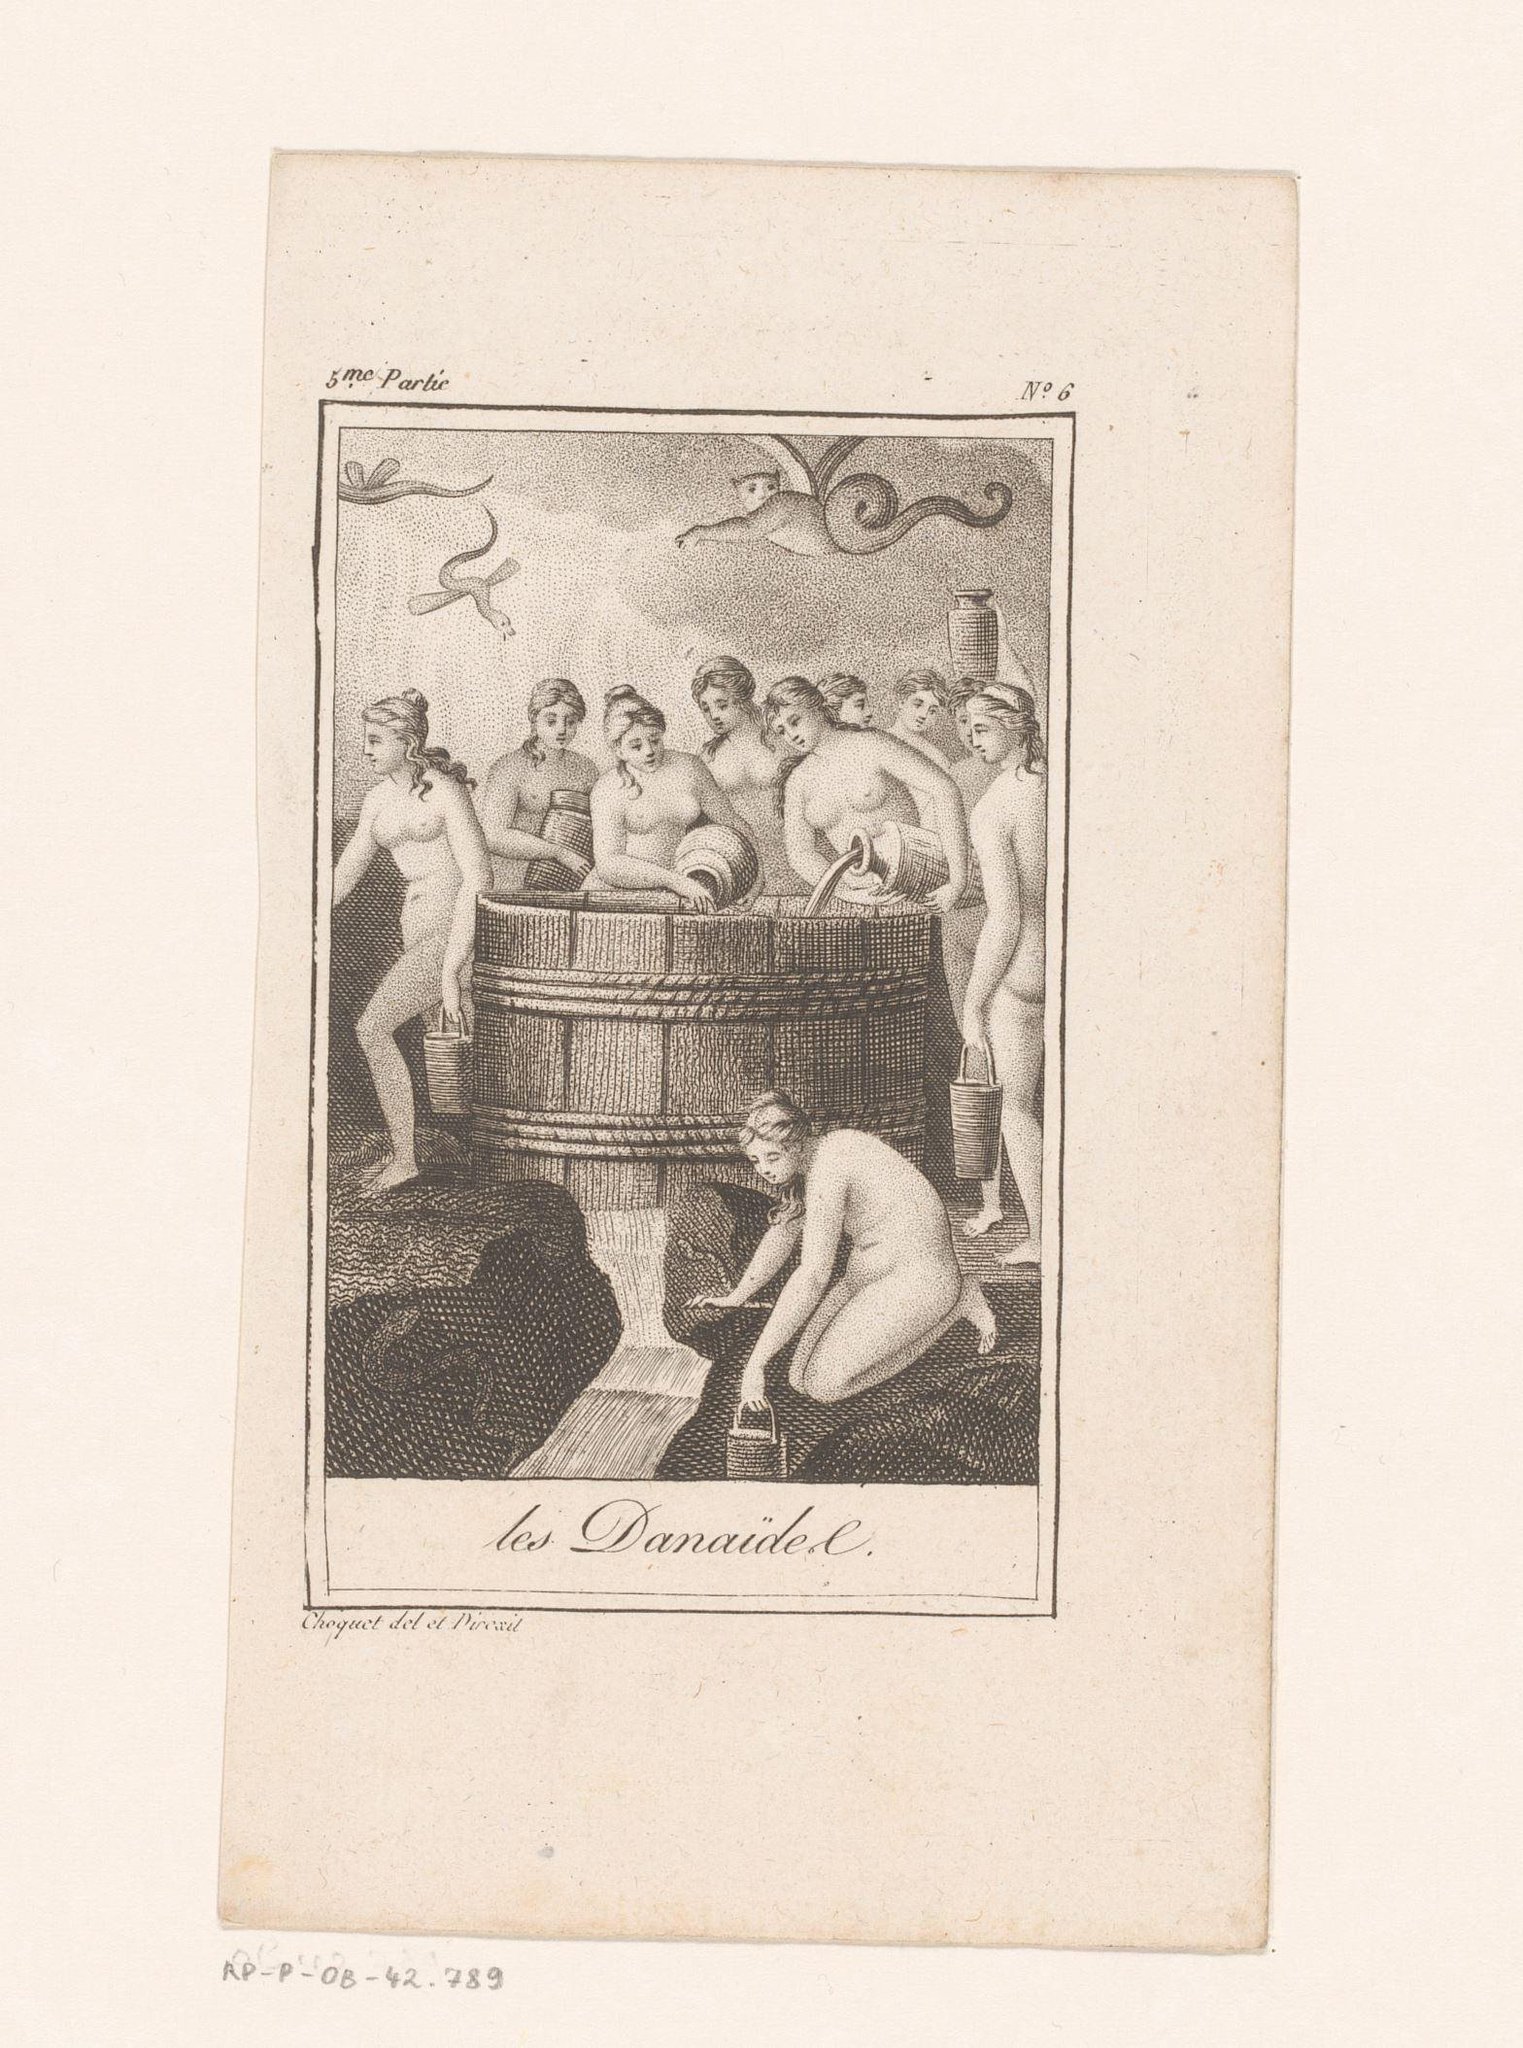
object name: print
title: Danaïden aan een waterput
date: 1784-1824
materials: paper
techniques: etching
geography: france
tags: the danaids pouring water into a perforated vessel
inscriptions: collector's mark: Lugt 2228